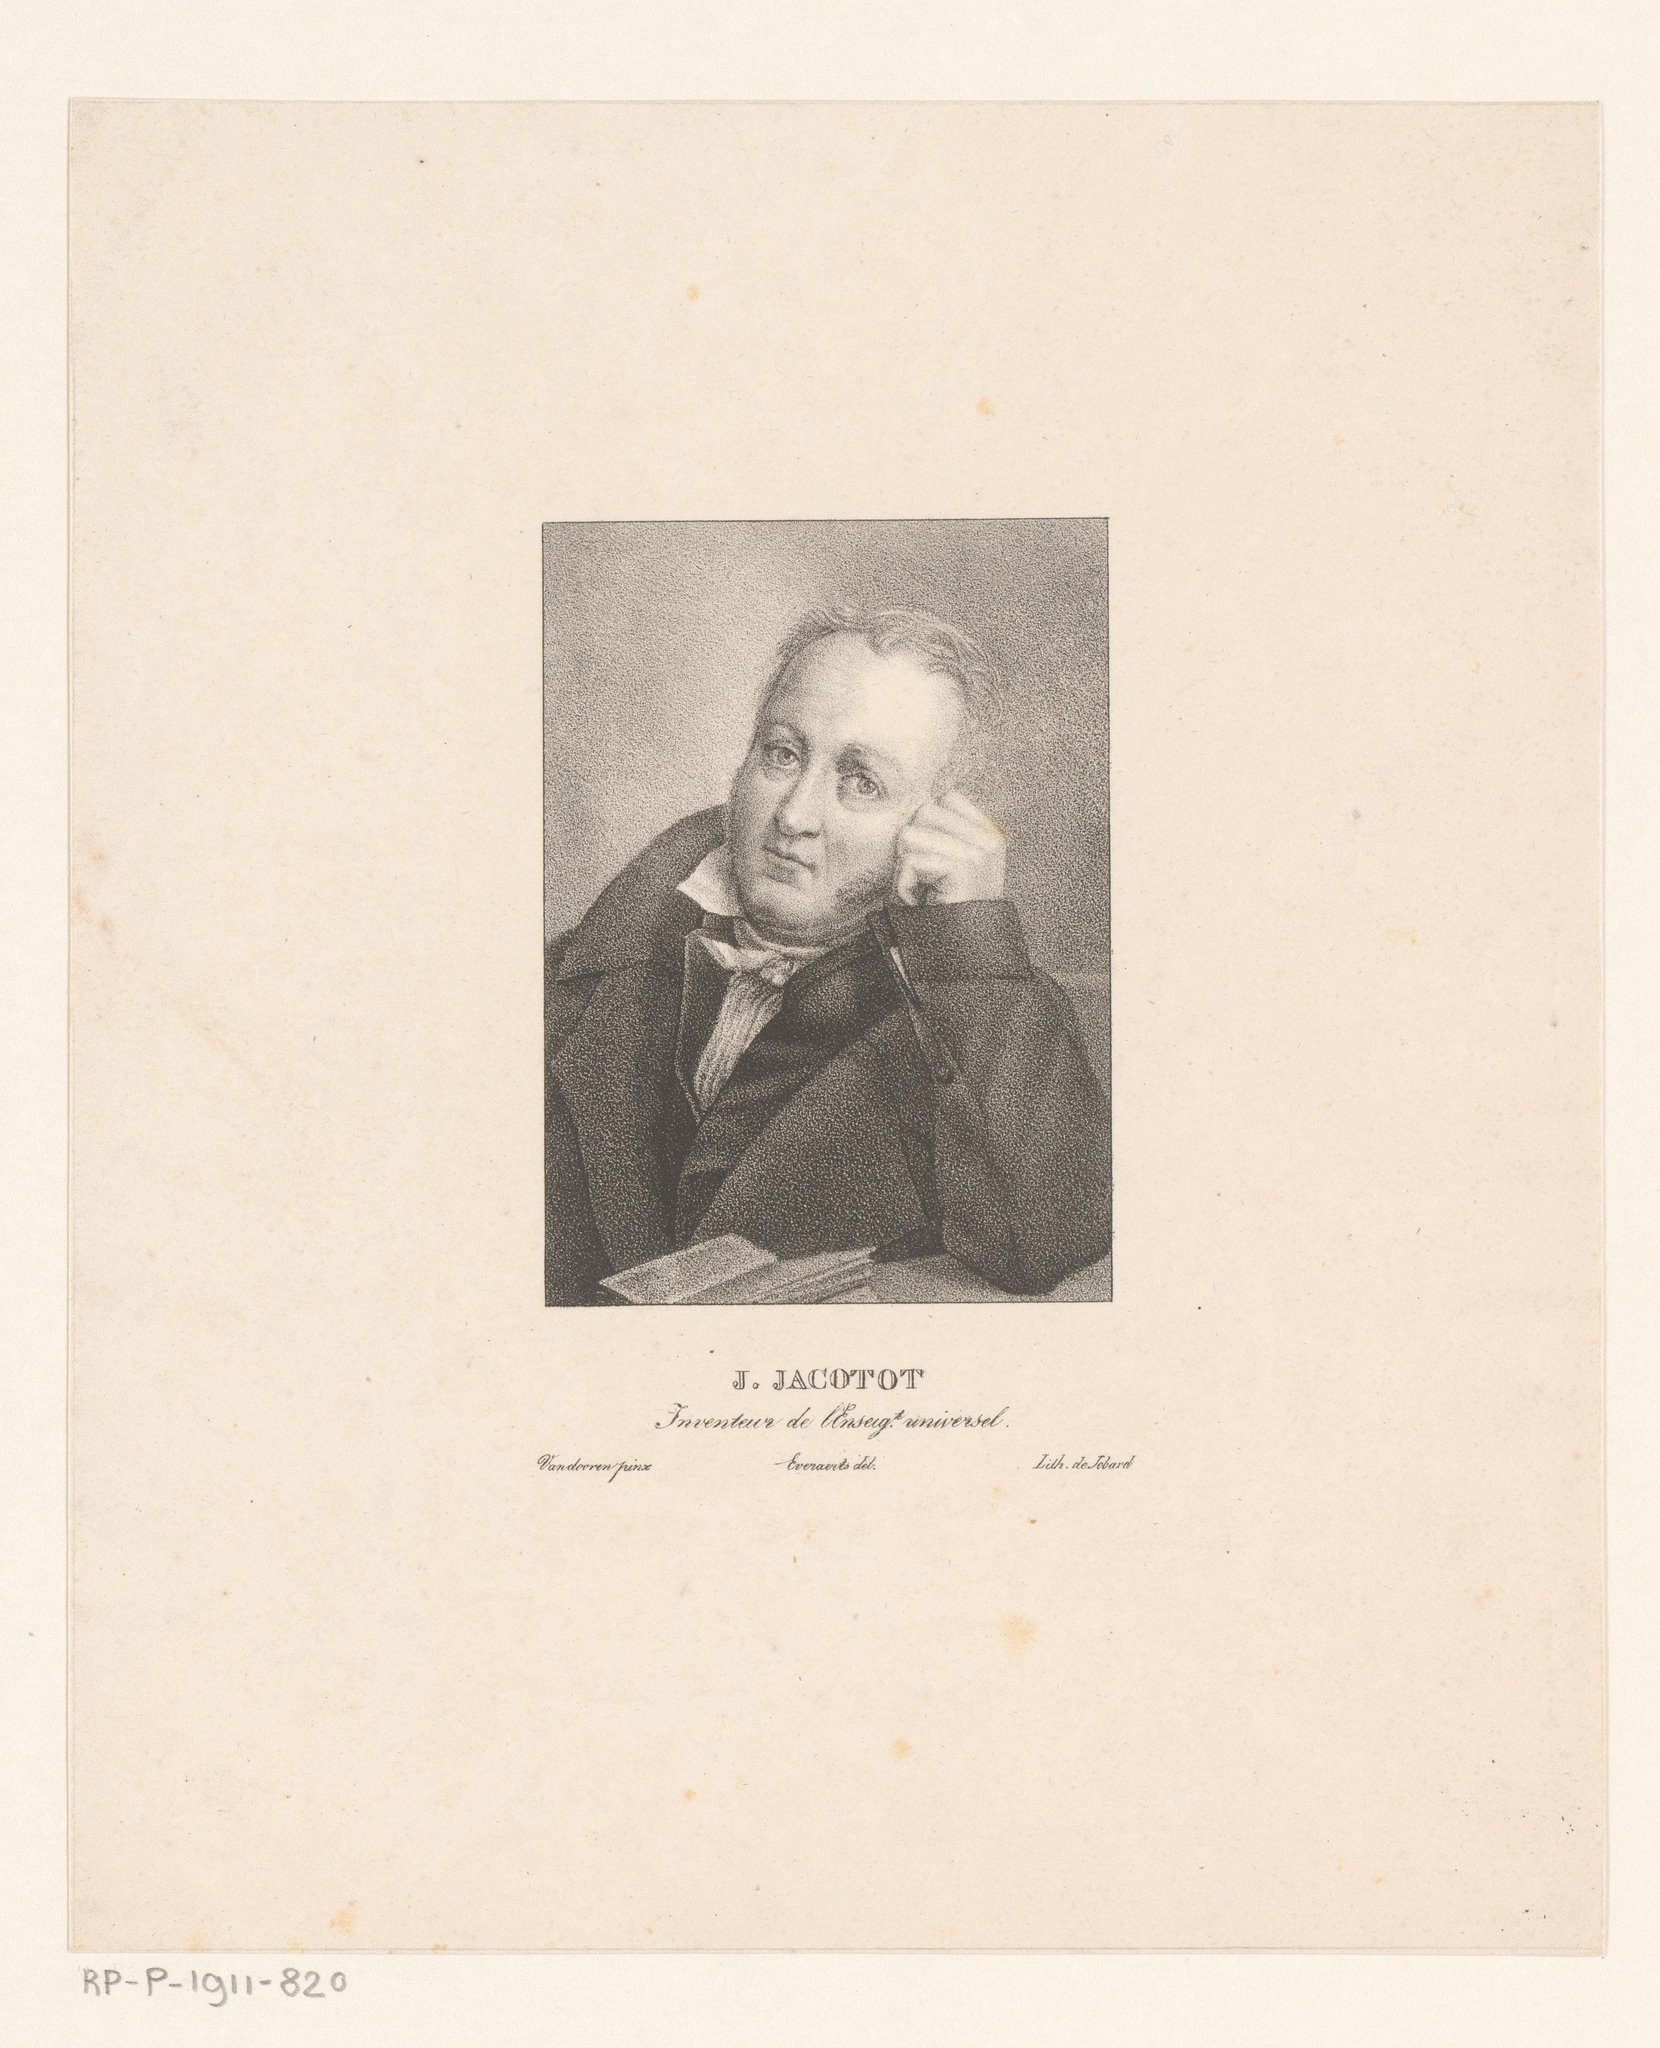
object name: print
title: J. Jacotot Inventeur de l'Enseig.t universel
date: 1802-1861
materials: paper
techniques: lithograph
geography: brussels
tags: paris, historical persons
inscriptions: collector's mark: Lugt 2228